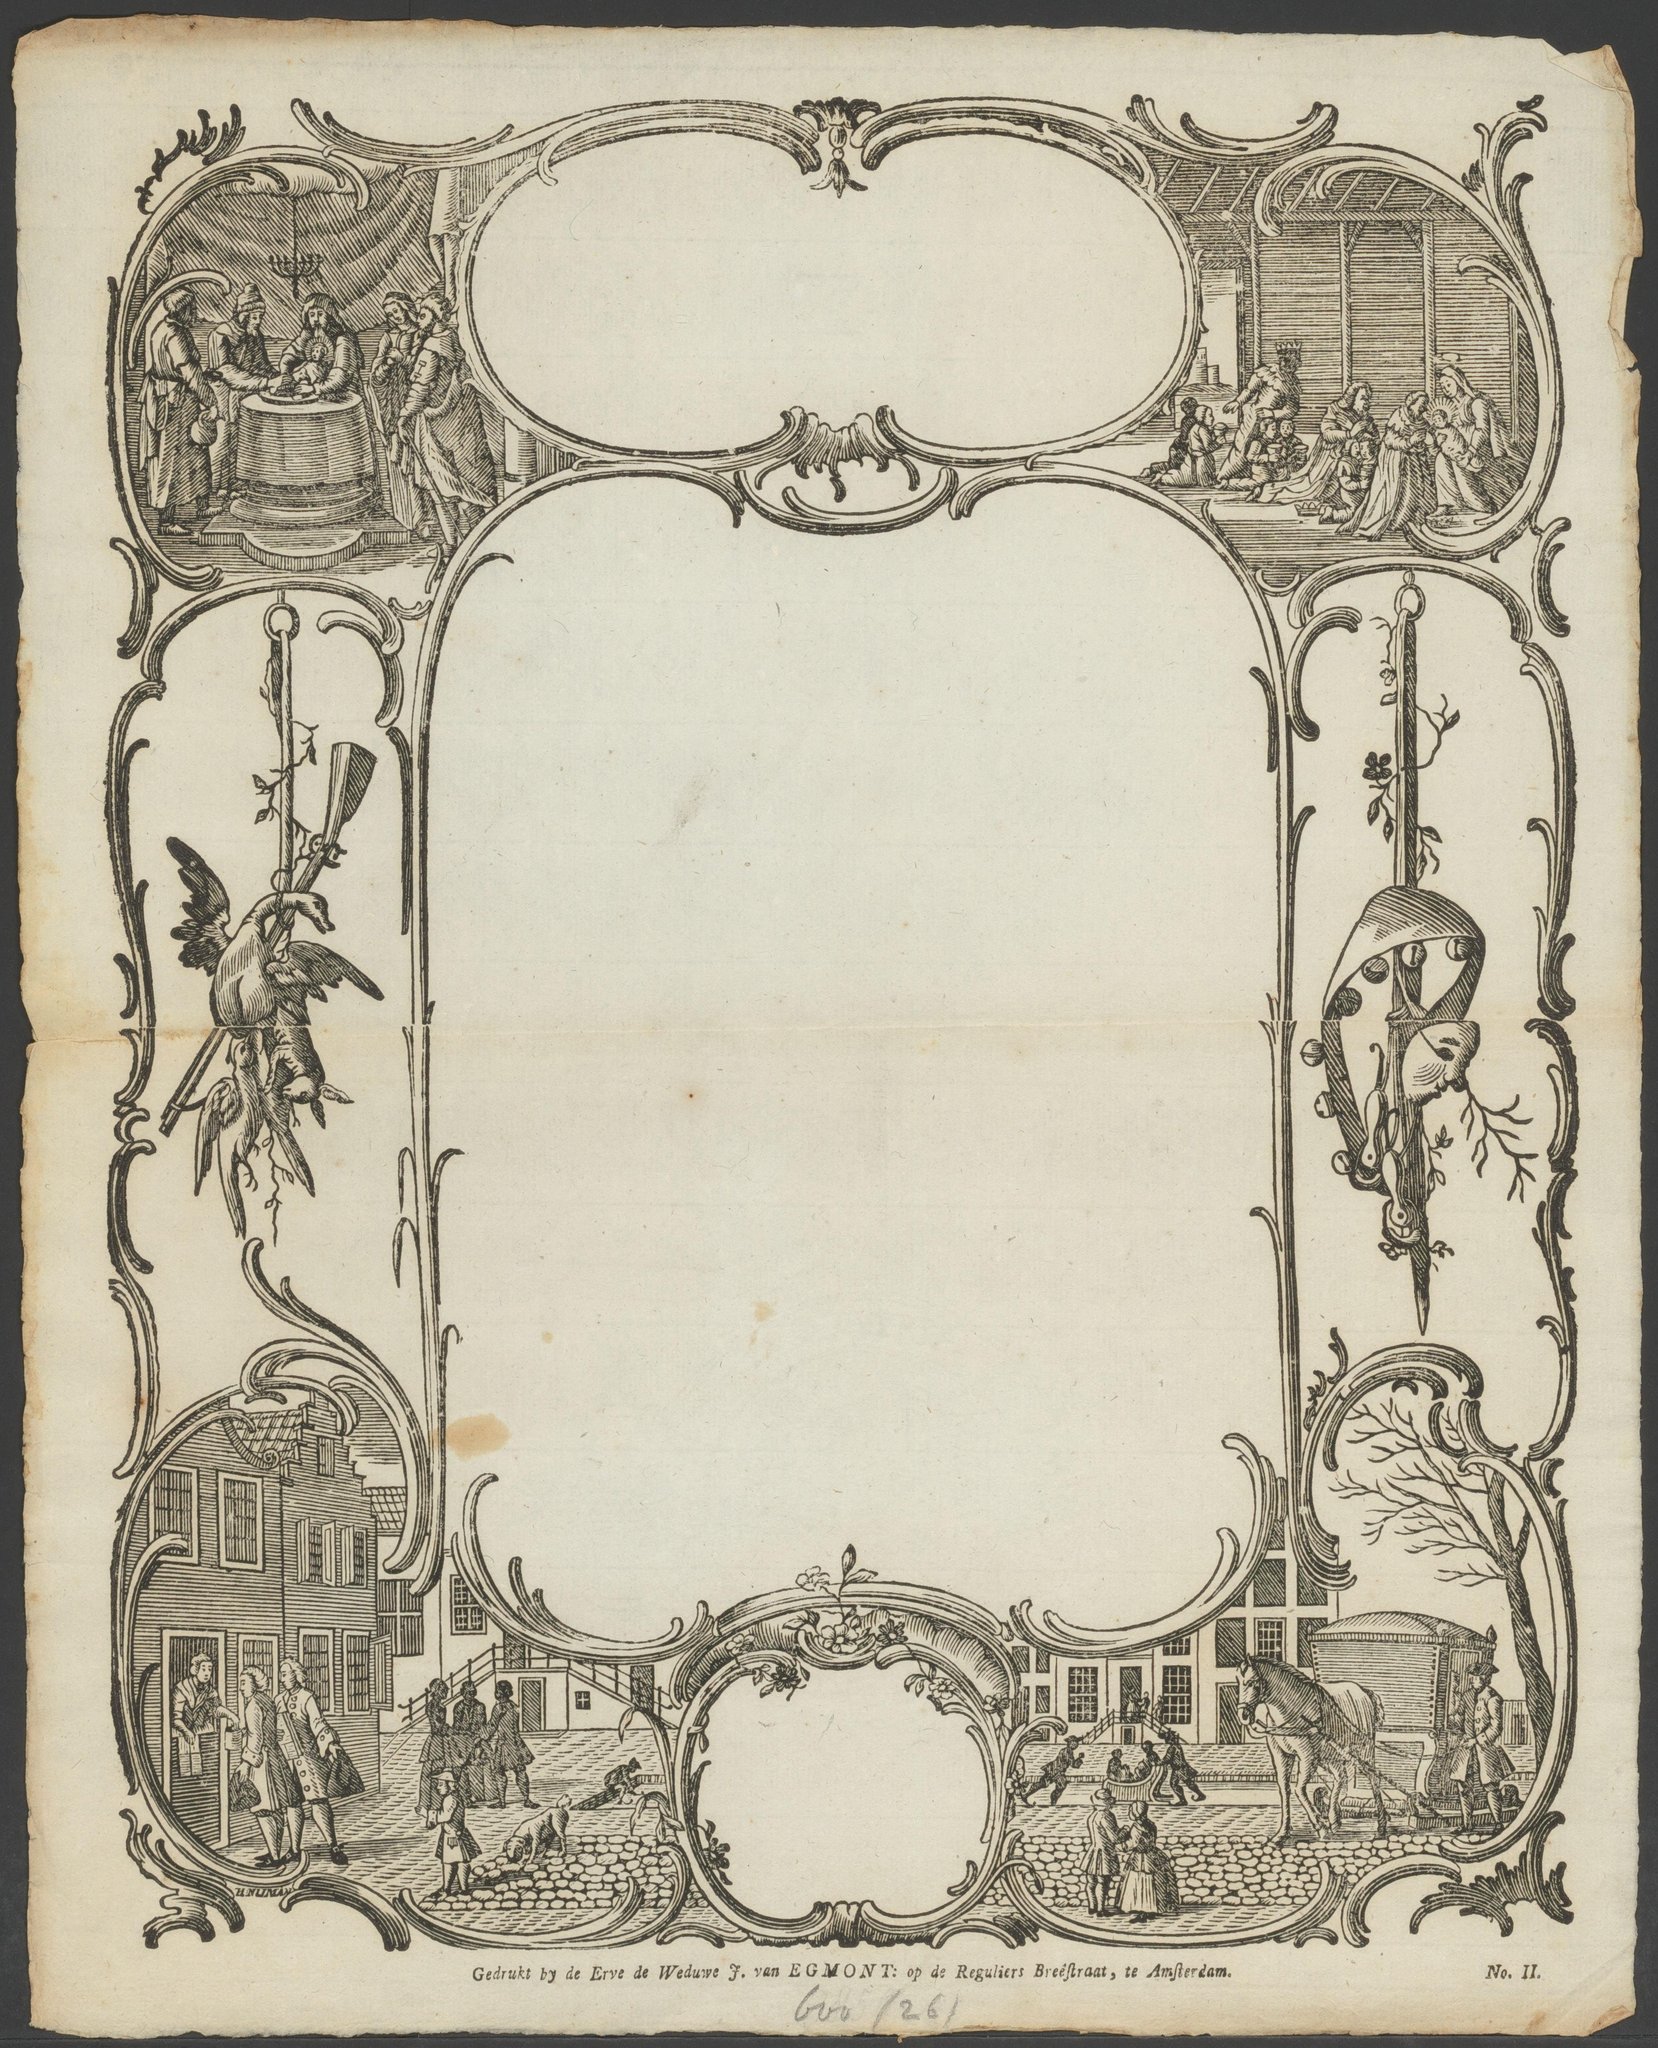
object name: print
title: Blanco gedrukte wensbrief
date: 1761-1804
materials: paper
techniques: woodcut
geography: amsterdam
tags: story of the birth of christ (luke 2:1-20), public road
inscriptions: collector's mark: Lugt 1641, collector's mark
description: Onbeschreven gedrukte wensbrief voor Kerstmis, Nieuwjaar, Pasen of Pinksteren. Met boven twee scènes uit het verhaal van de geboorte van Christus en onder twee stadsgezichten. Genummerd rechtsonder: No. II. Onderwerpsrubrieken binnen de Atlas Zeden en Gewoonten: Nieuwjaars- en kermiswenschen.